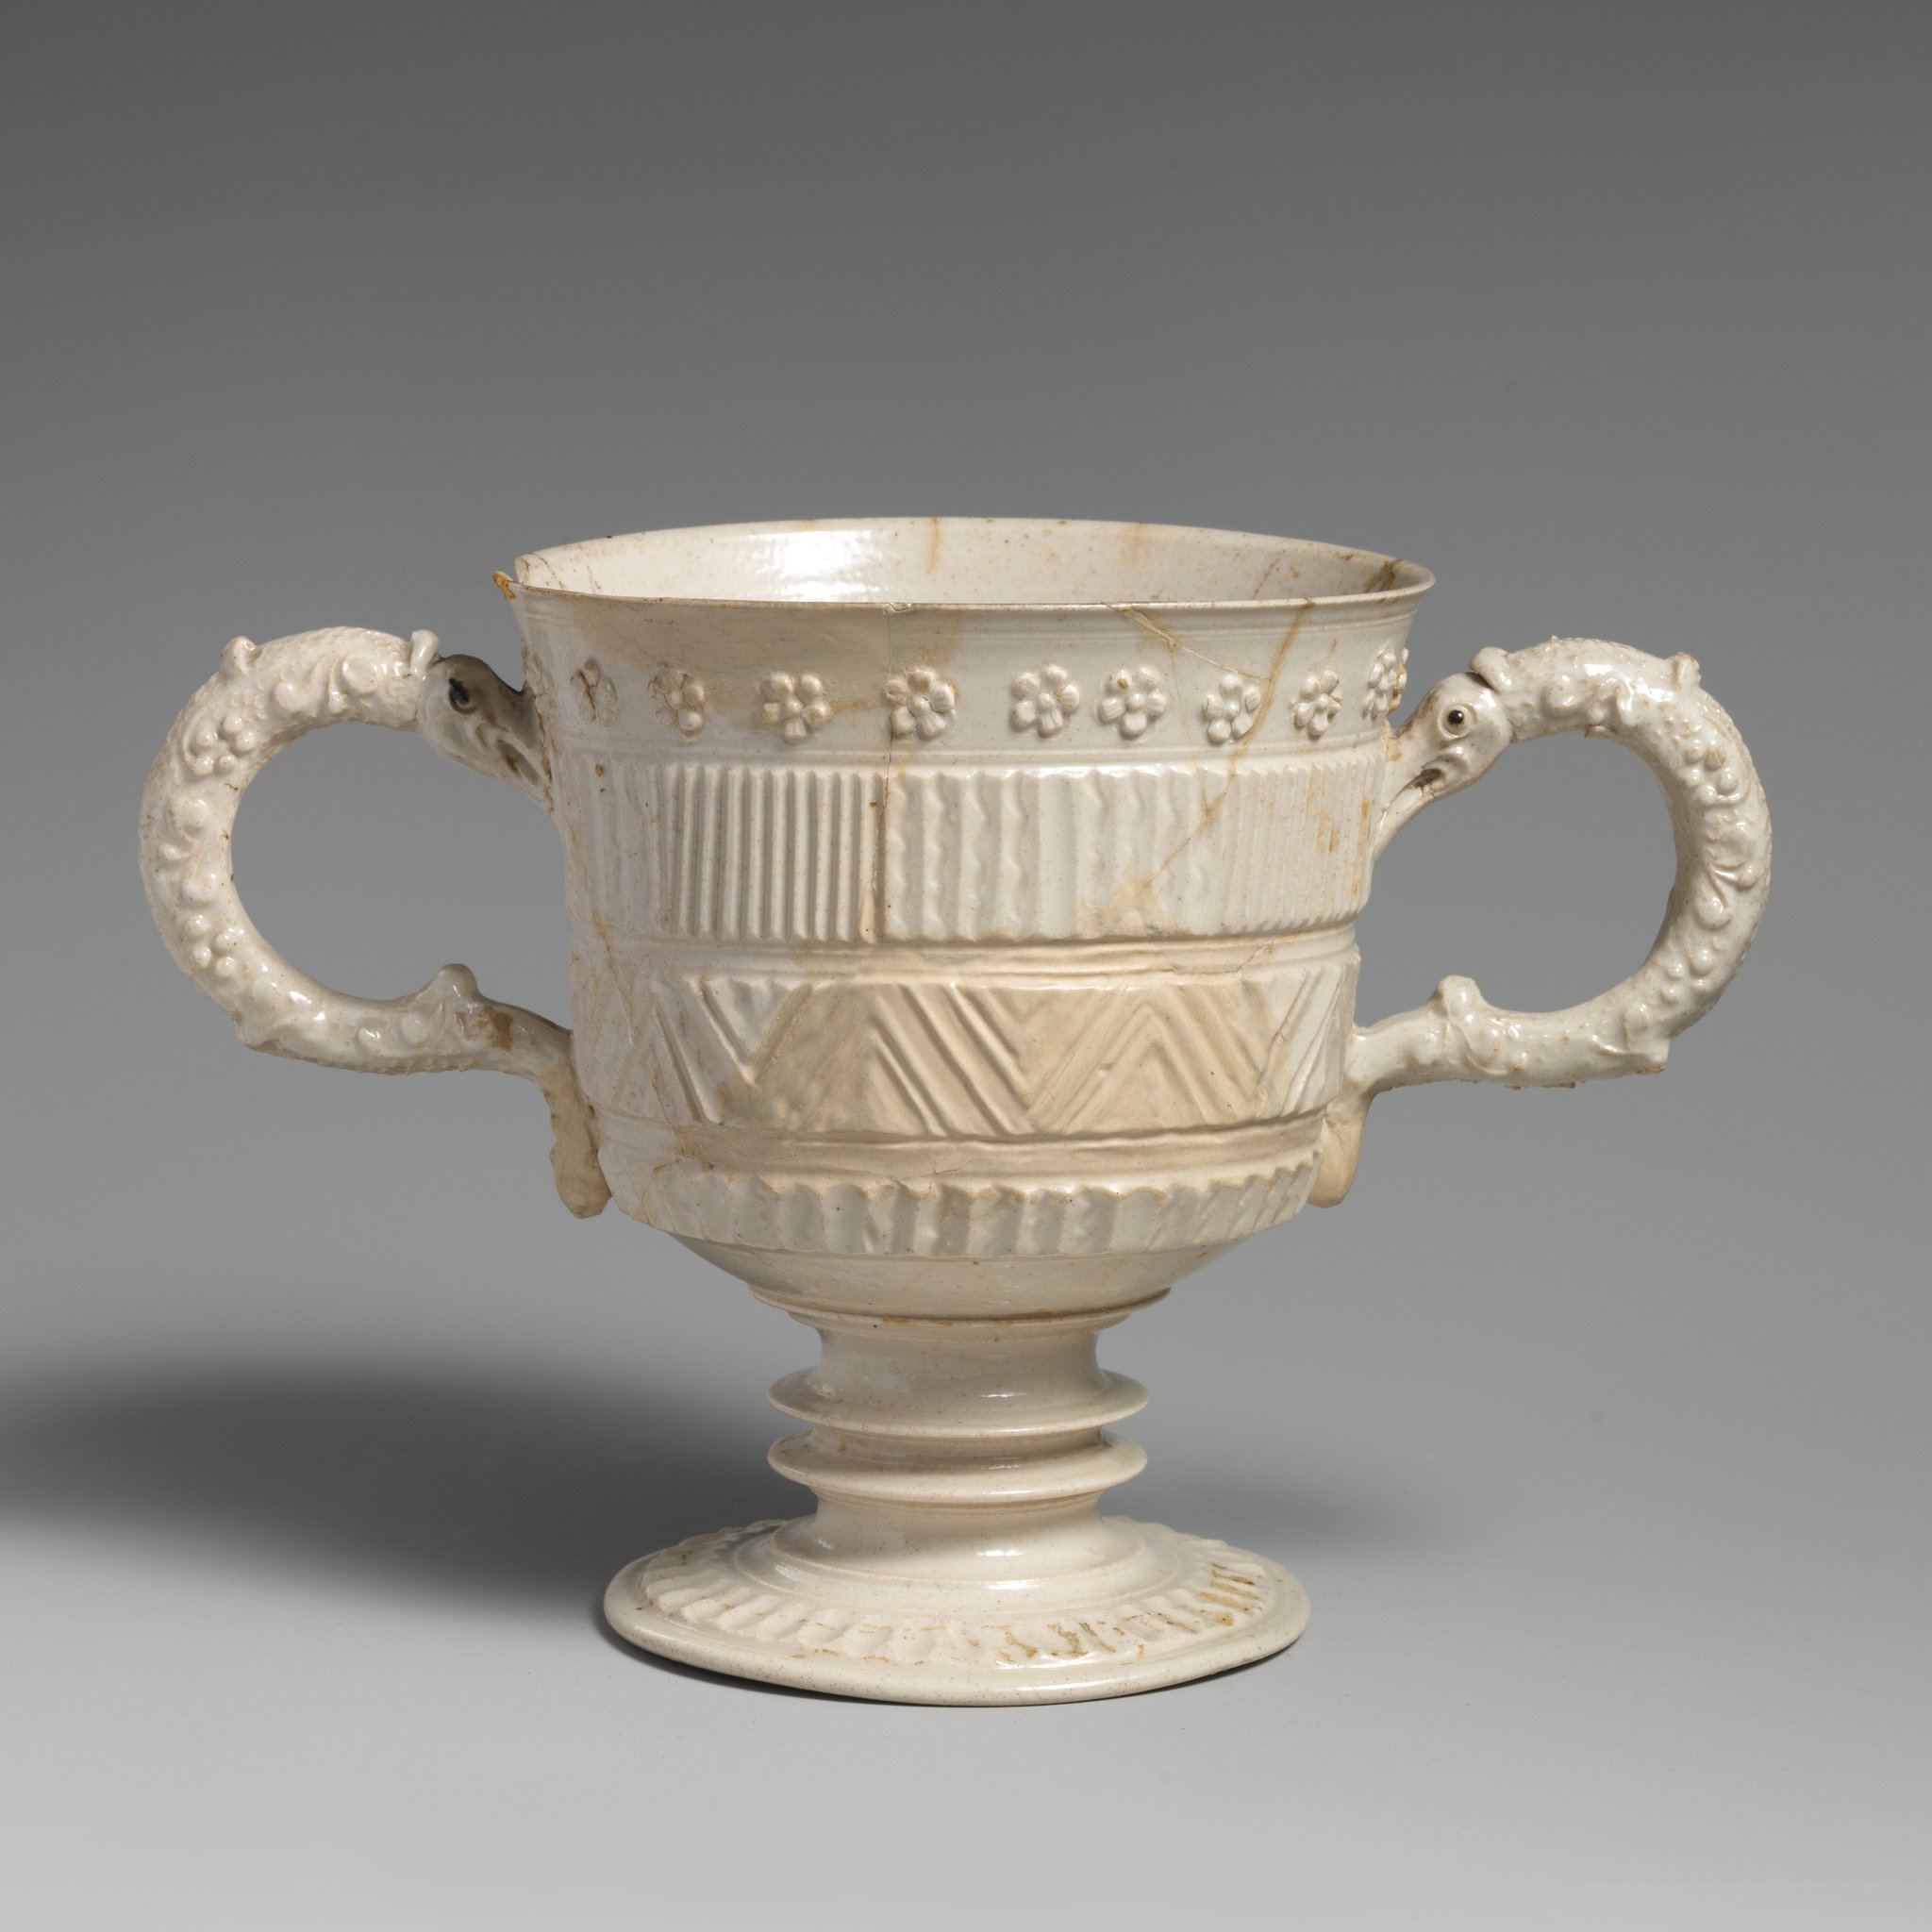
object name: cup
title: Two-handled cup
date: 1701-1800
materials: stoneware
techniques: salt glaze